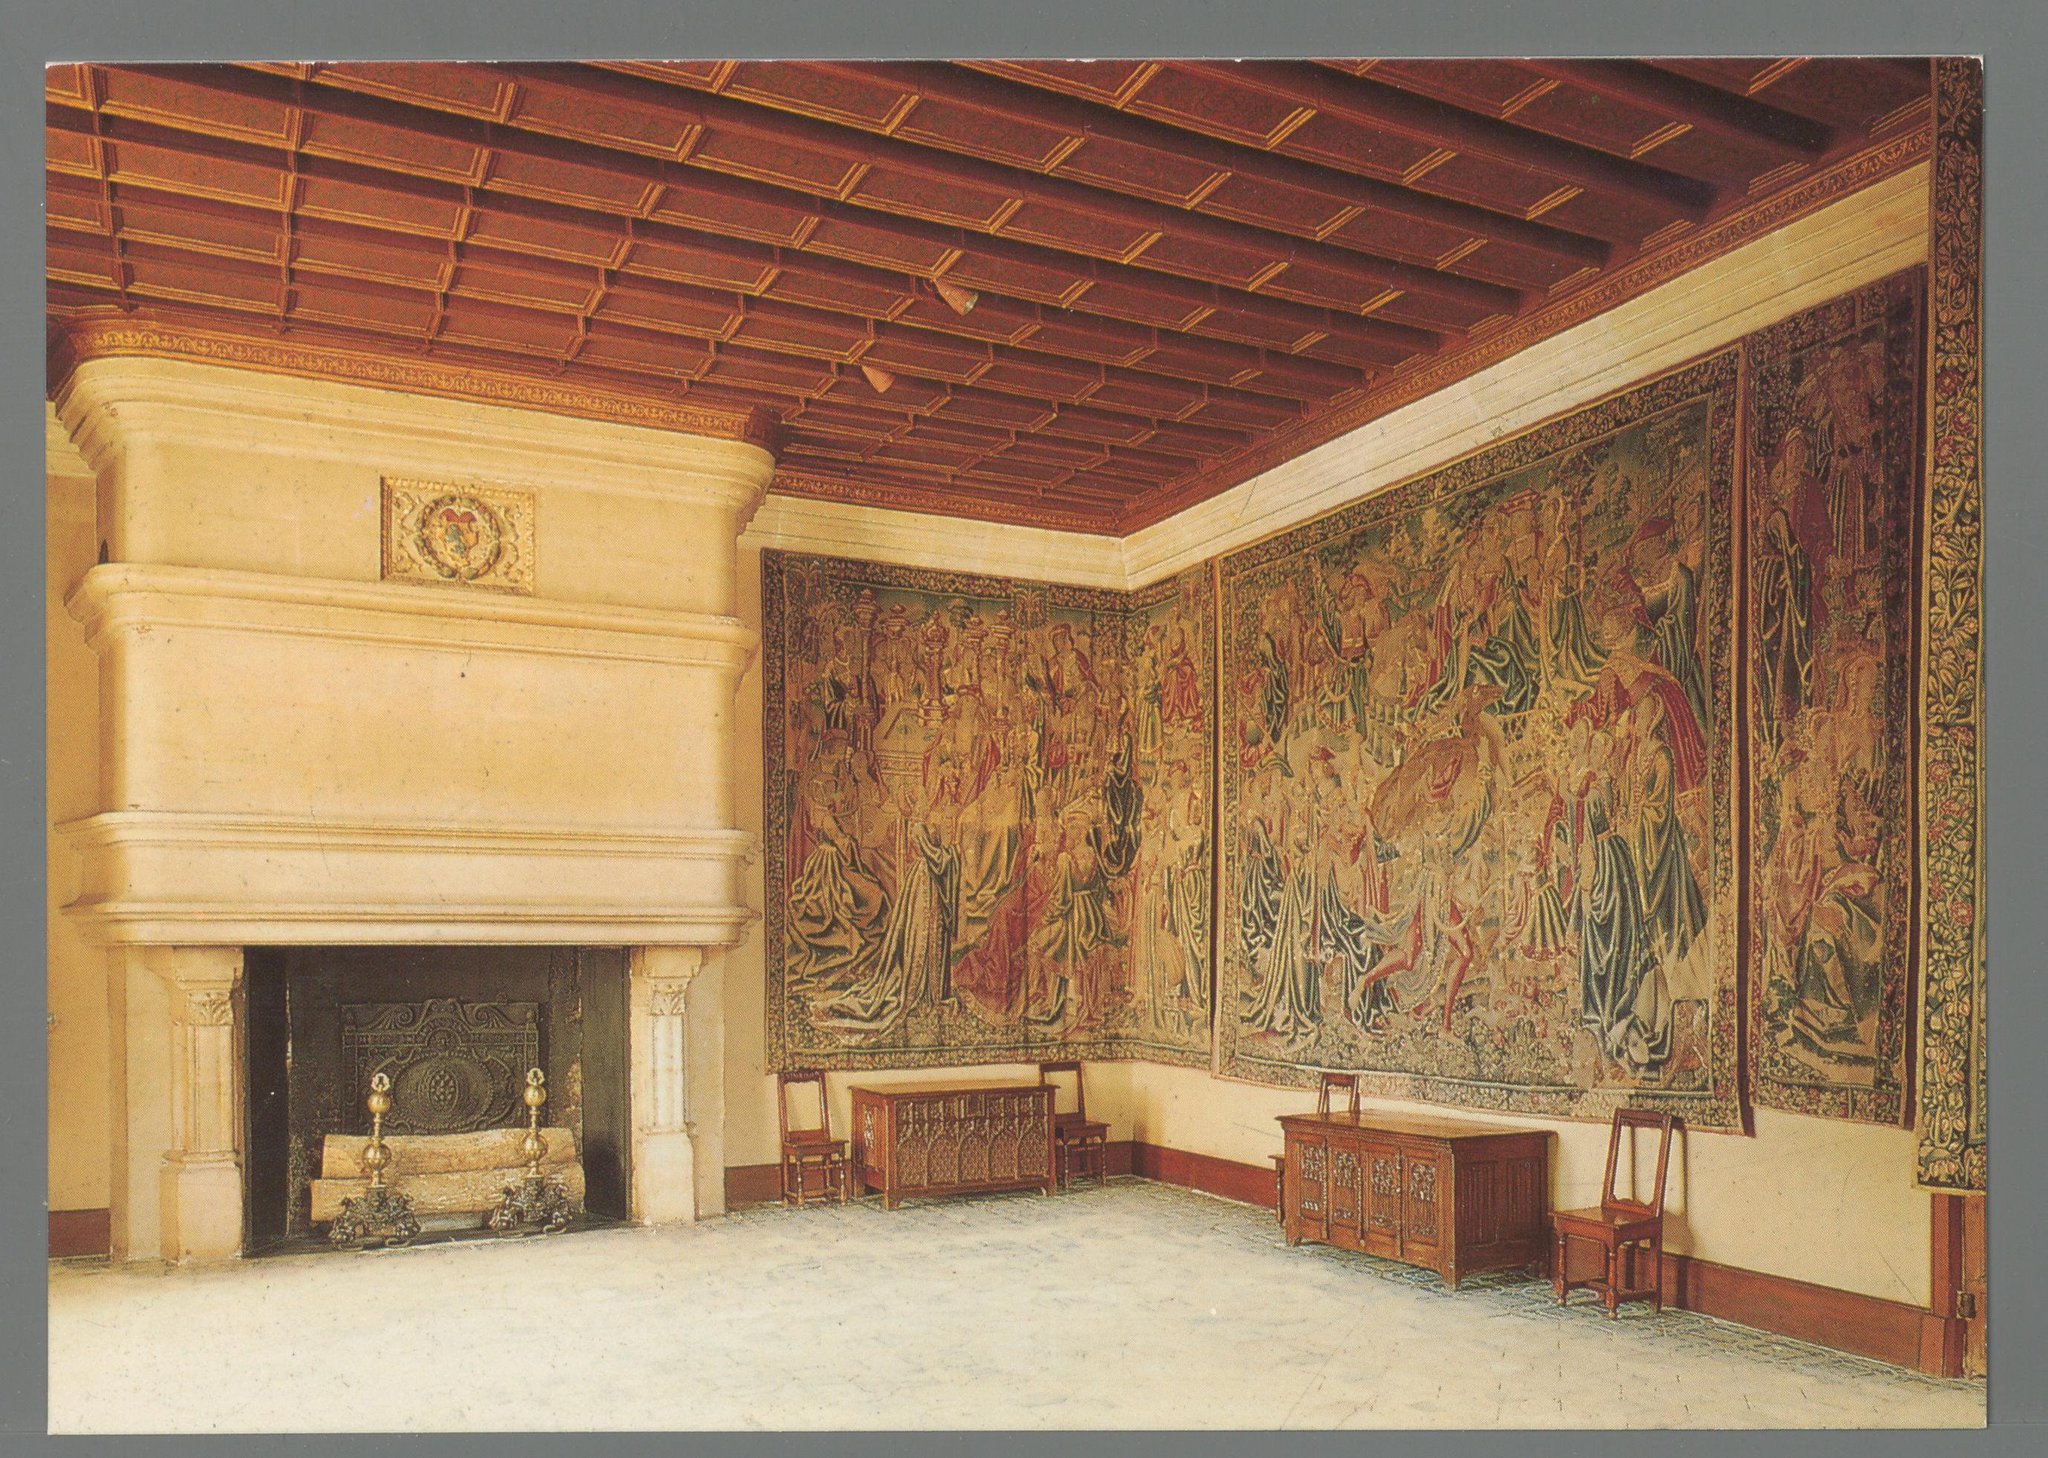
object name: photomechanical print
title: Chateau de Chenonceau (I-et-L.-37). La Salle des Gardes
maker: Anonymous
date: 1958-1990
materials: cardboard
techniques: offset printed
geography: chenonceaux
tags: castle, interior ~ representation of a building, tapestry